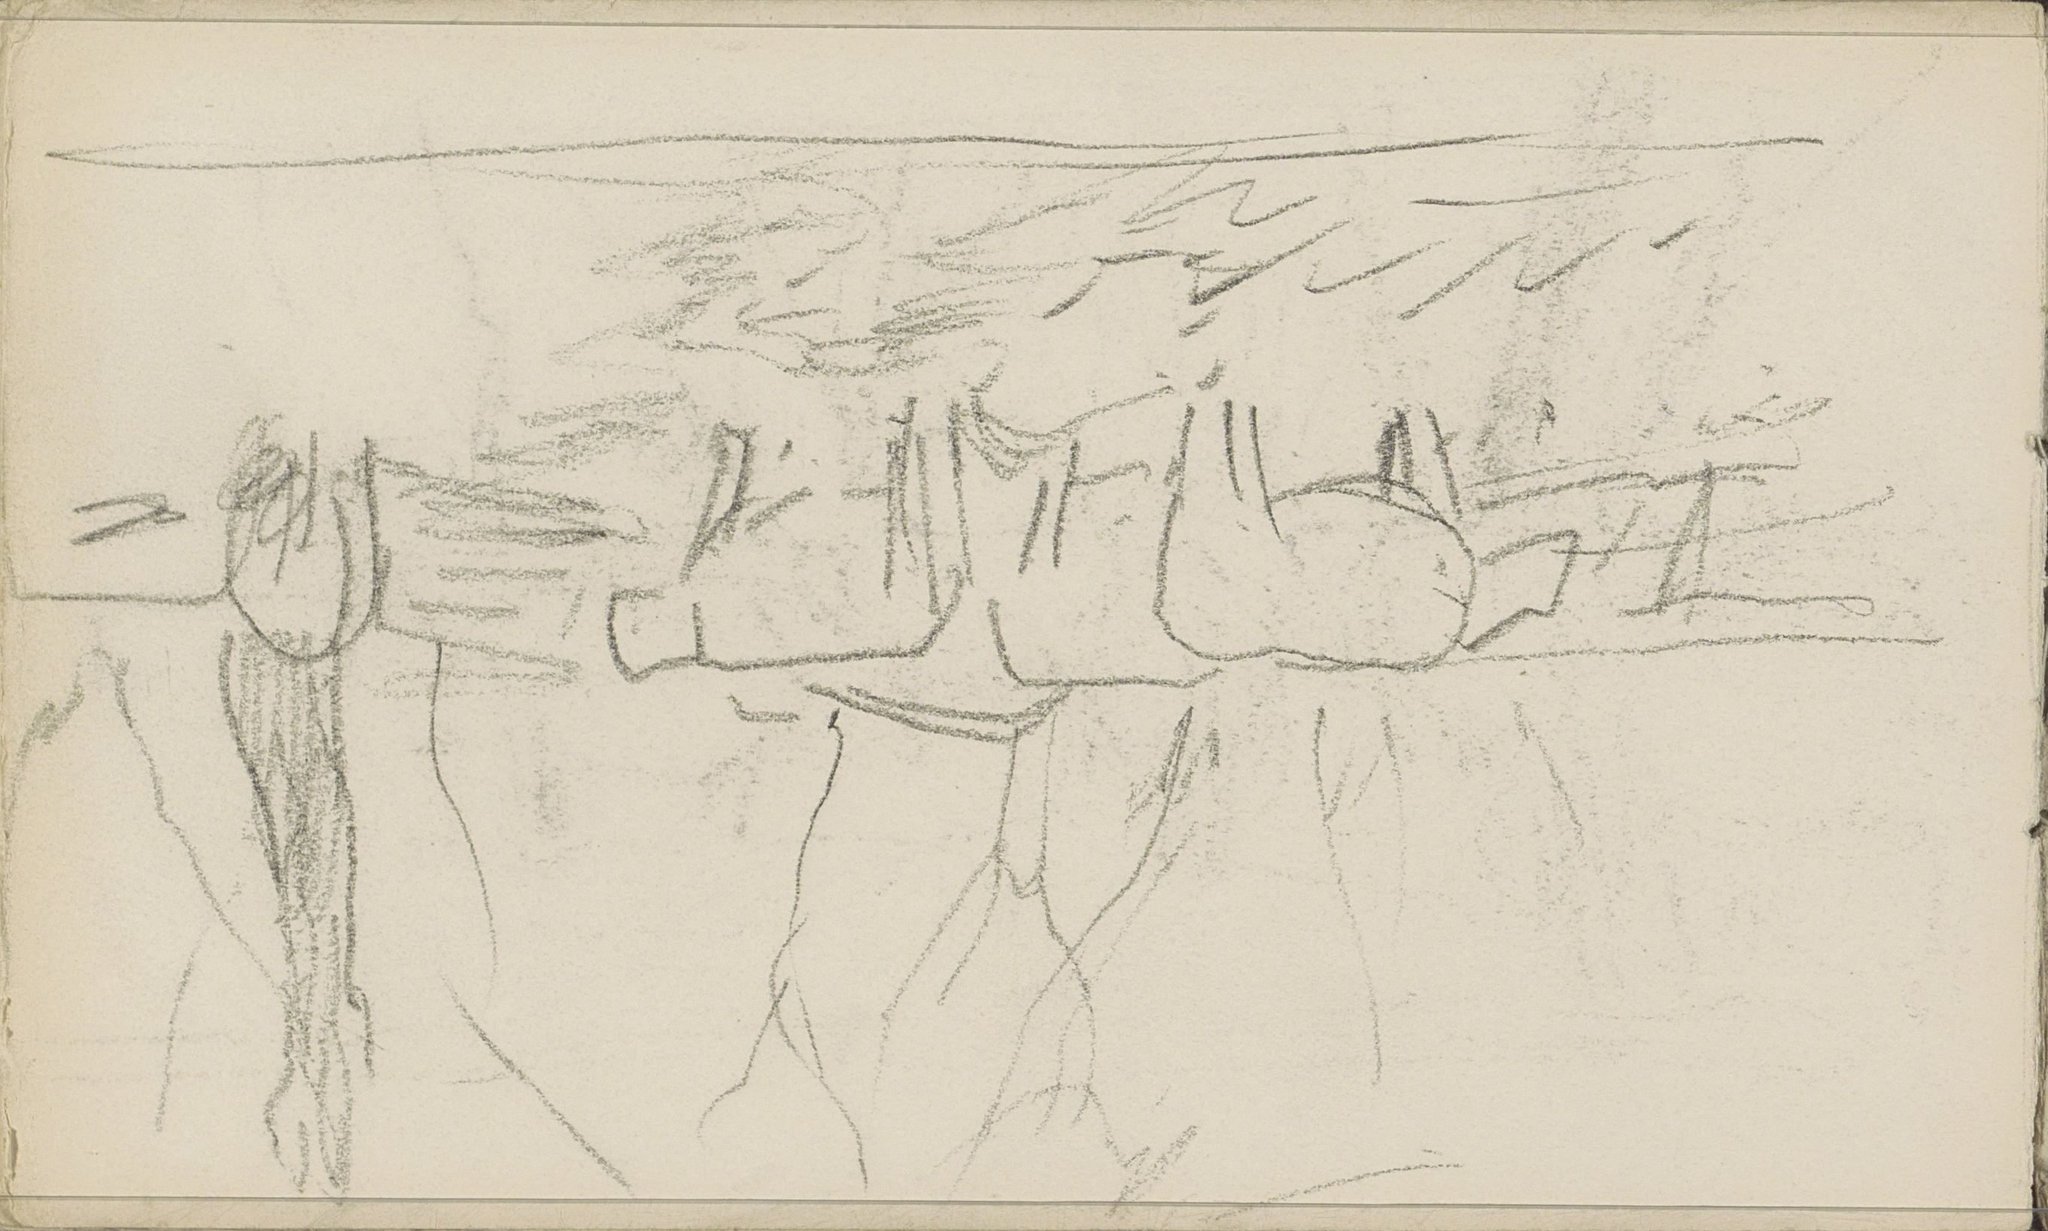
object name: sketchbook leaf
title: Koeien in een weiland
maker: anton mauve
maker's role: draughtsman, painter, print maker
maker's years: 1838-1888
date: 1848-1888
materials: chalk, paper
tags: cow, meadow, pasture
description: Blad 18 verso uit een schetsboek met 33 bladen.